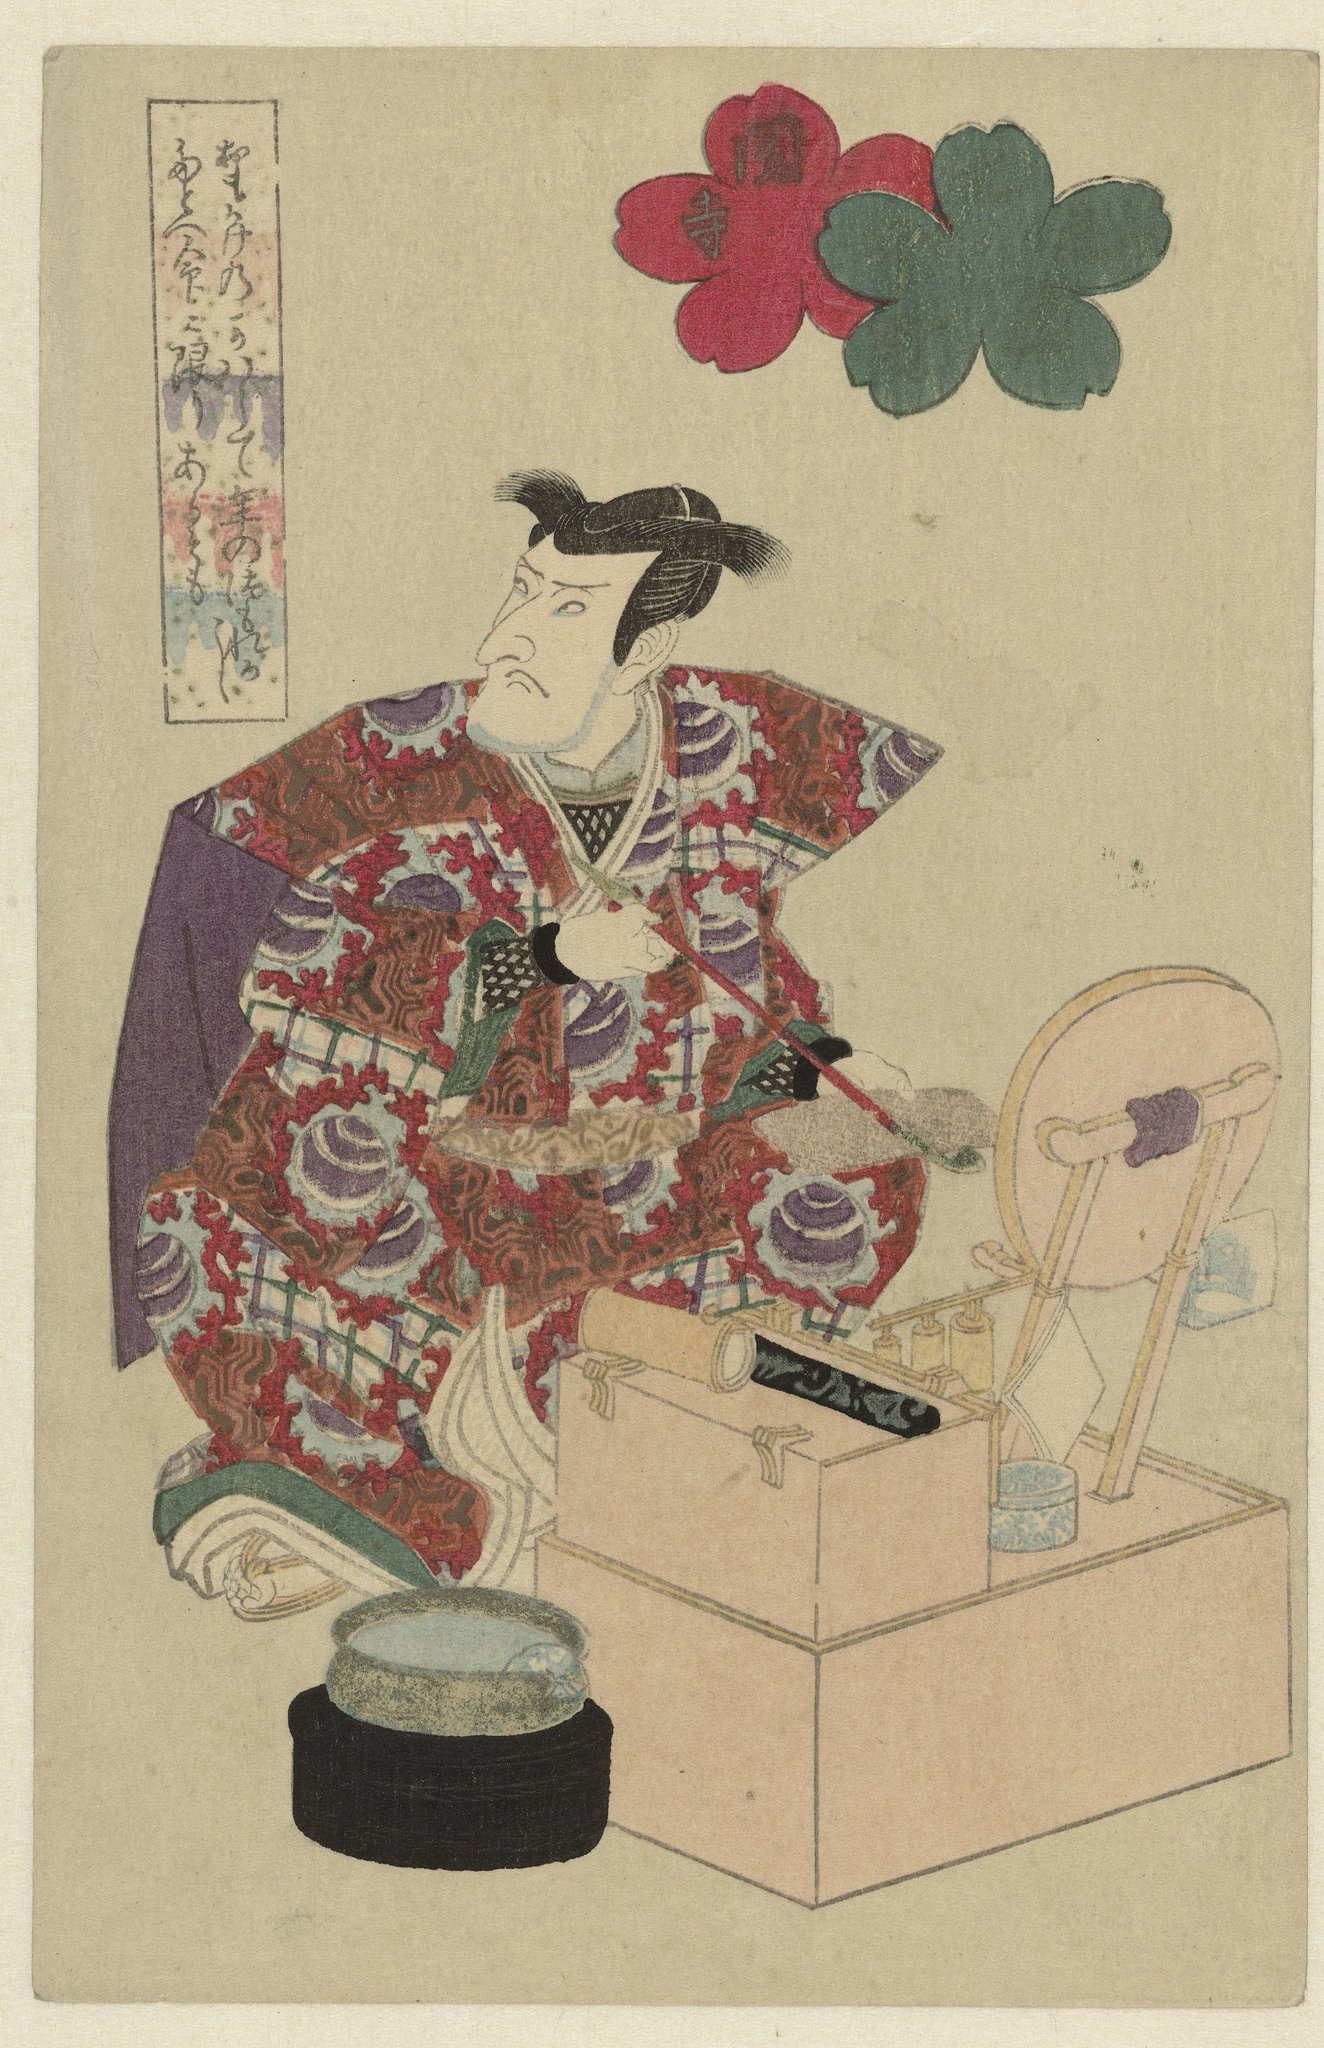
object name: print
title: Man at His Dressing Table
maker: utagawa kunisada (i)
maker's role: print maker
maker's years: 1786-1865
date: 1825-1830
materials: paper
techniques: blind stamped, woodcut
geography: japan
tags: making toilet, actor (on the stage), kneeling on both knees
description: De toneelspeler Matsumoto Kôshirô V (1764-1838) zit voor zijn kaptafel. Hij rookt een lange pijp. De titel Sekidera is een toespeling op het gelijknamige toneelstuk, waarin de acteur heeft gespeeld. Met één anoniem gedicht. Met de 'zeven Komachi', uit de titel, worden zeven gebeurtenissen uit het leven van de beroemde vrouwelijk dichter Ono no Komachi bedoeld. De relatie met Komachi in deze prent is dat het hoofd van de Sekidera tempel op een goed moment zijn volgelingen meenam om de oude Komachi te ontmoeten.